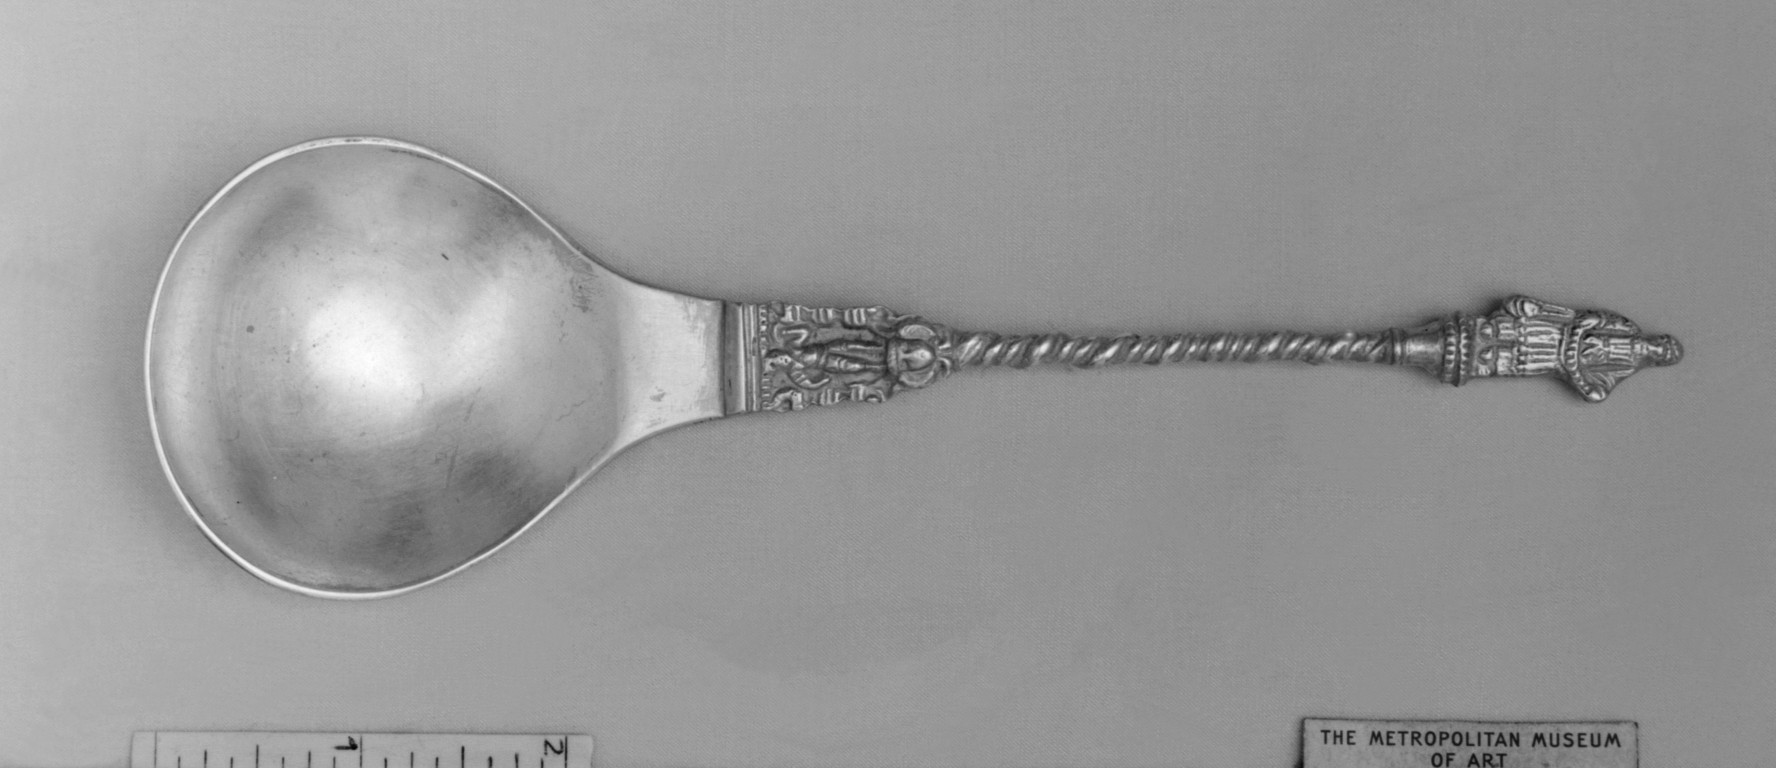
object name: spoon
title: Figure-top spoon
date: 1851-1900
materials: silver